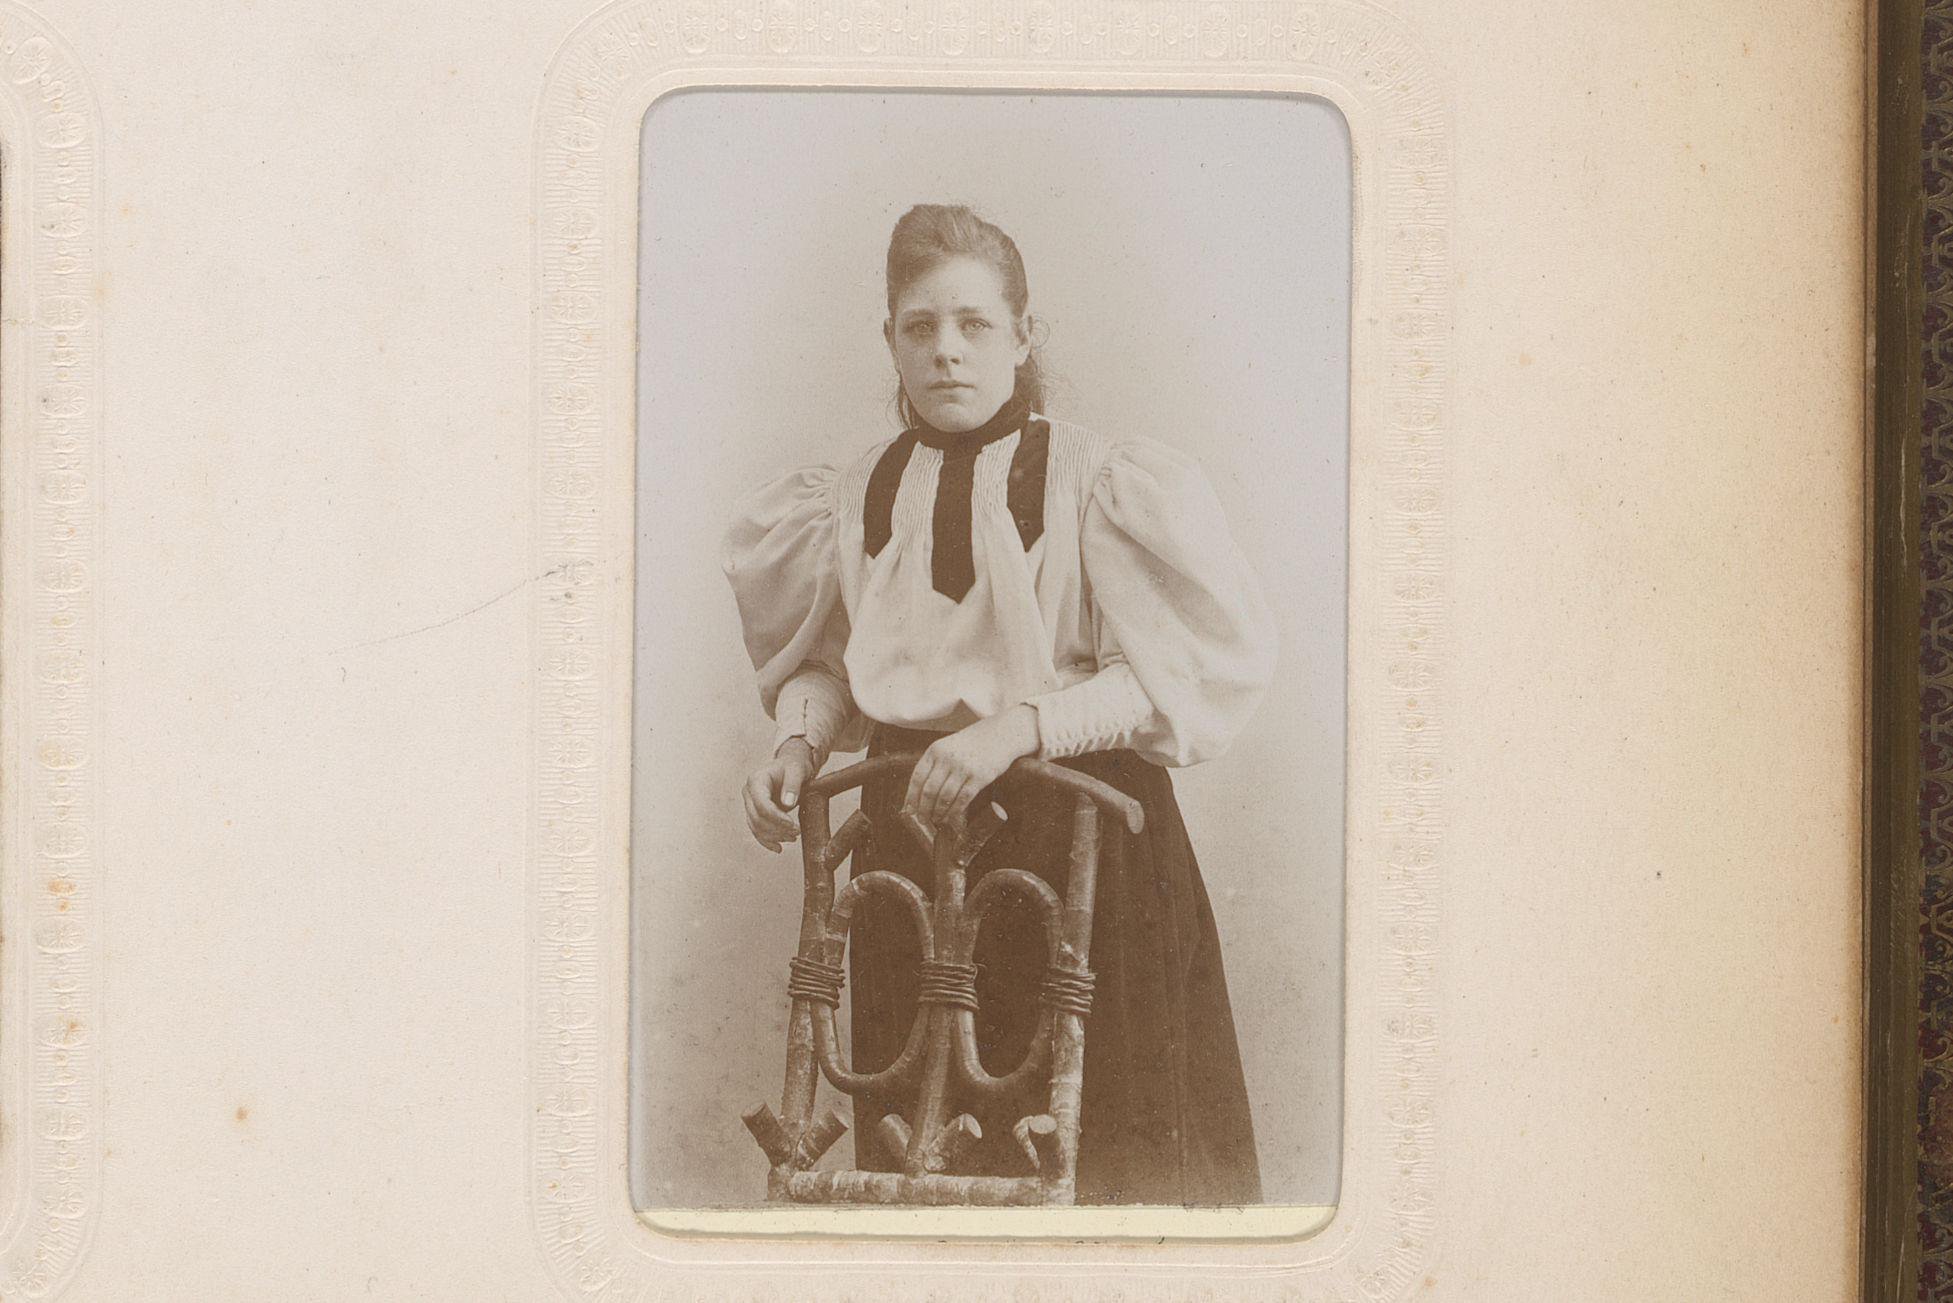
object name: carte de visite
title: Portret van een jonge vrouw, staand bij een stoel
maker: Anonymous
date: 1880-1920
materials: cardboard, photographic support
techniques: collodion silver print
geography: netherlands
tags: historical persons - bb - woman, standing figure - aa - female human figure, chair